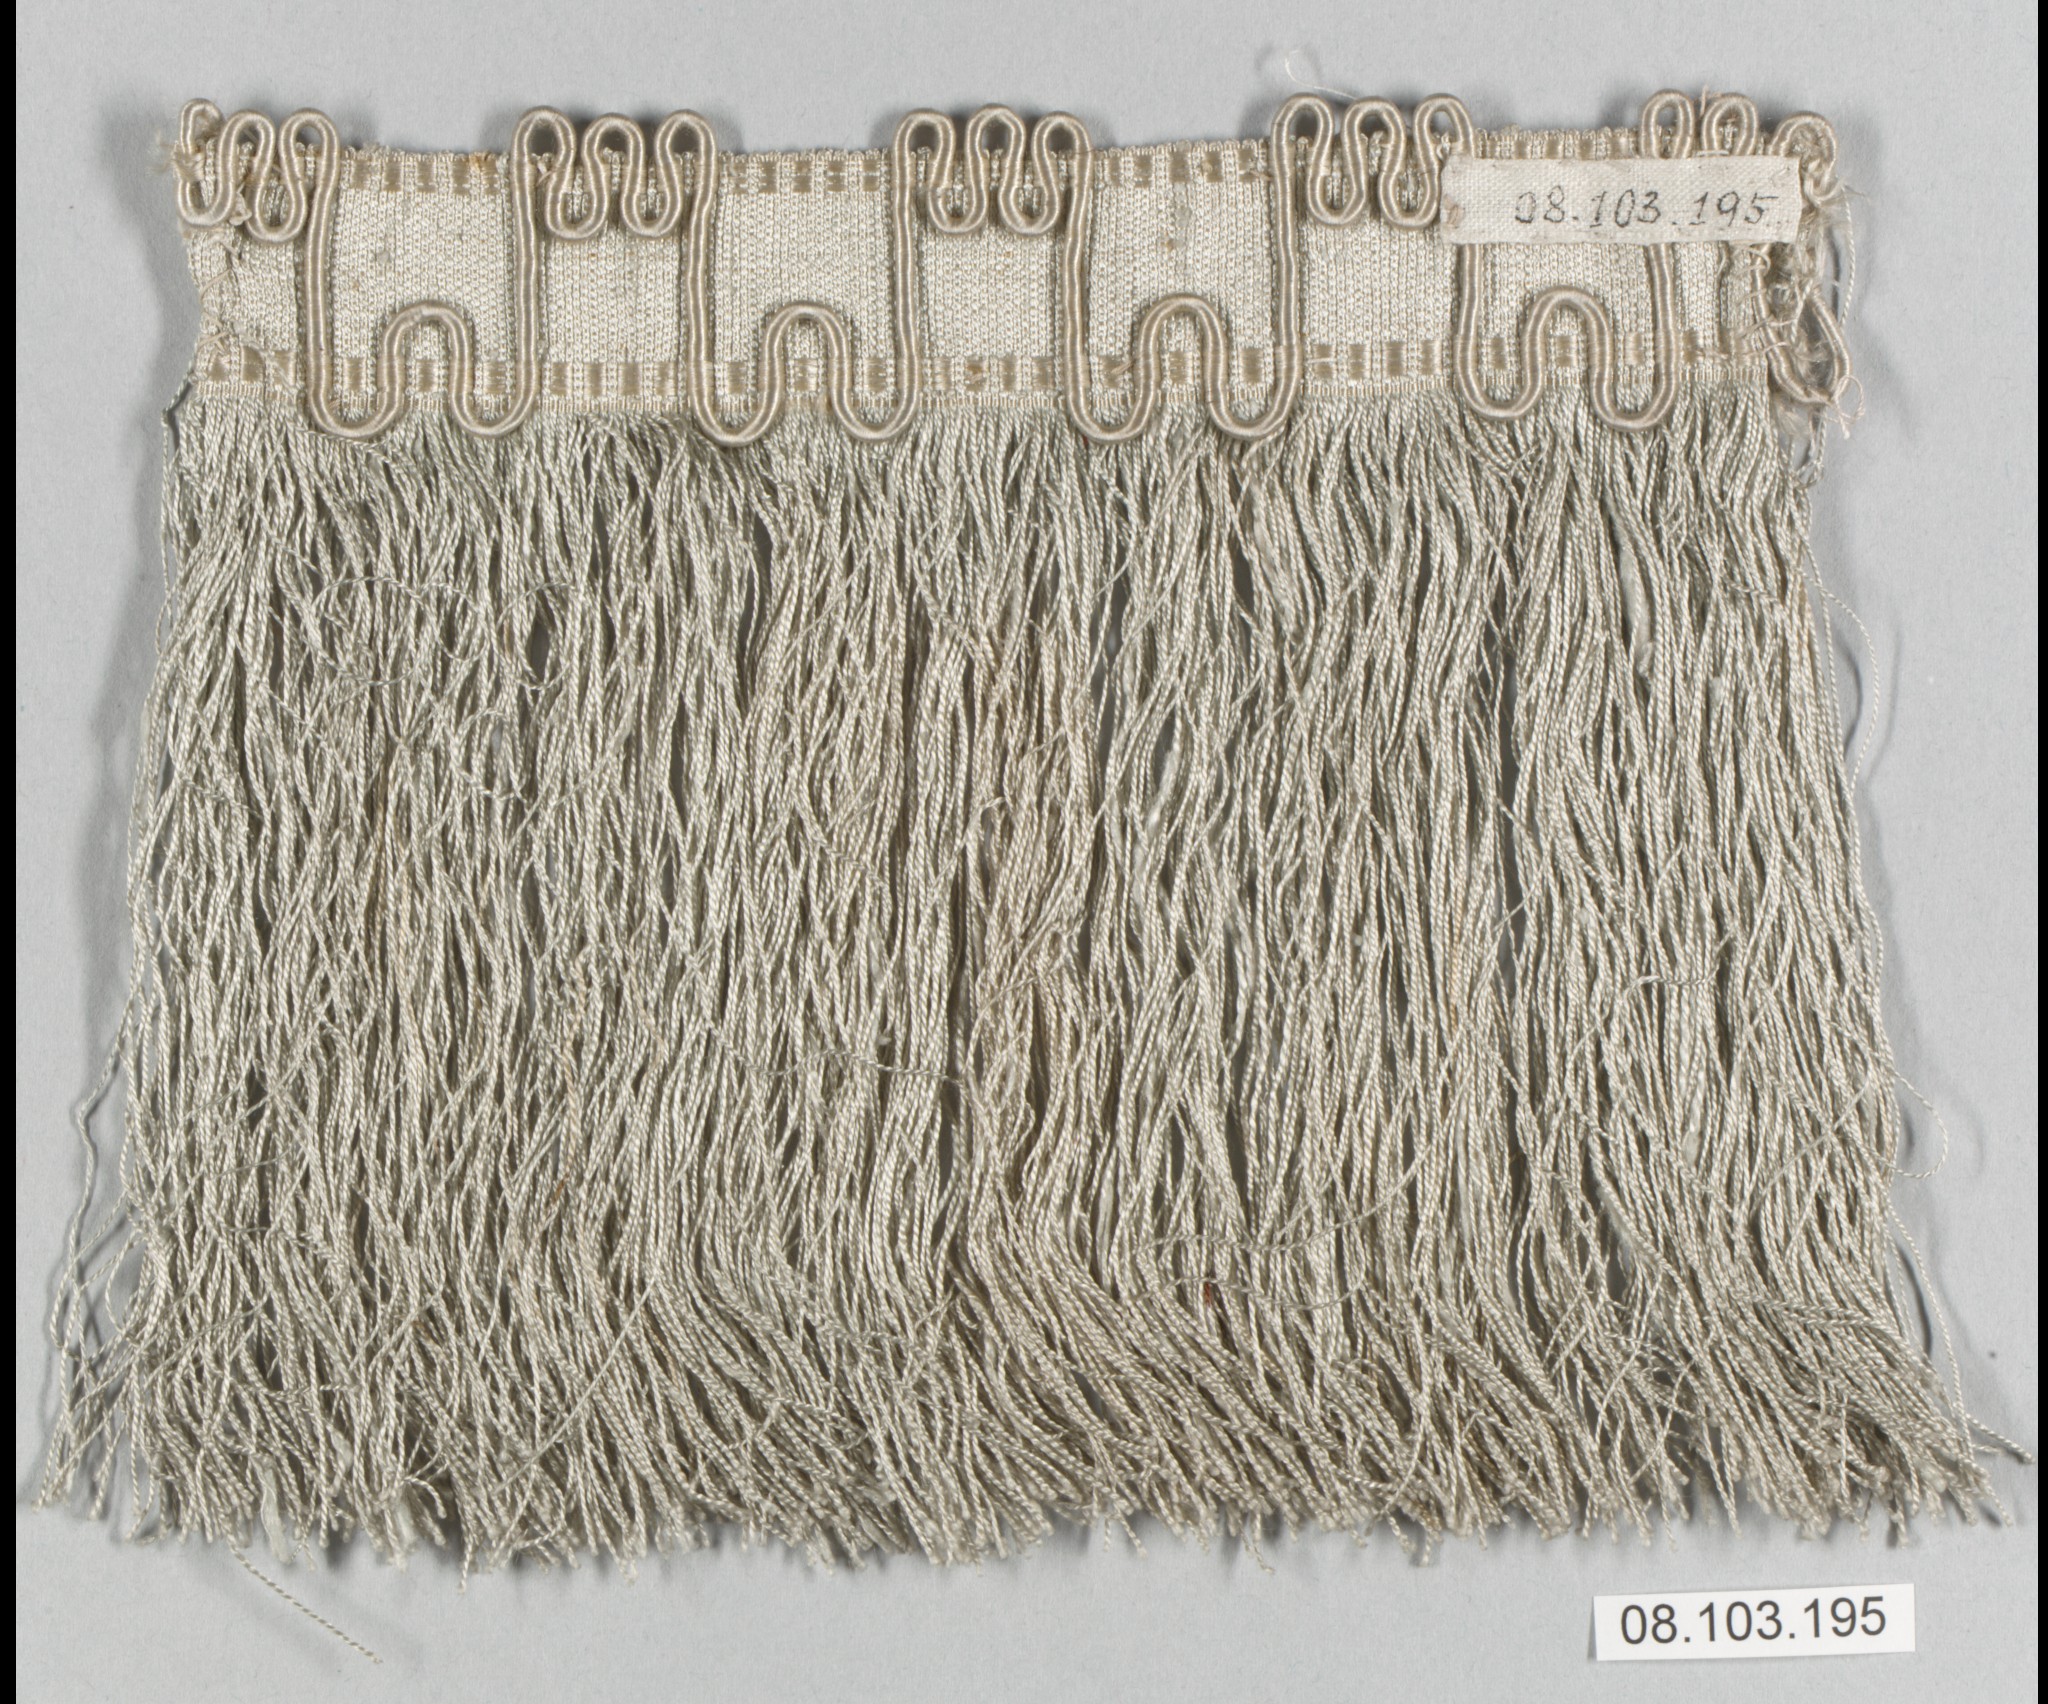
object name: fringe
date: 1801-1900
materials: silk